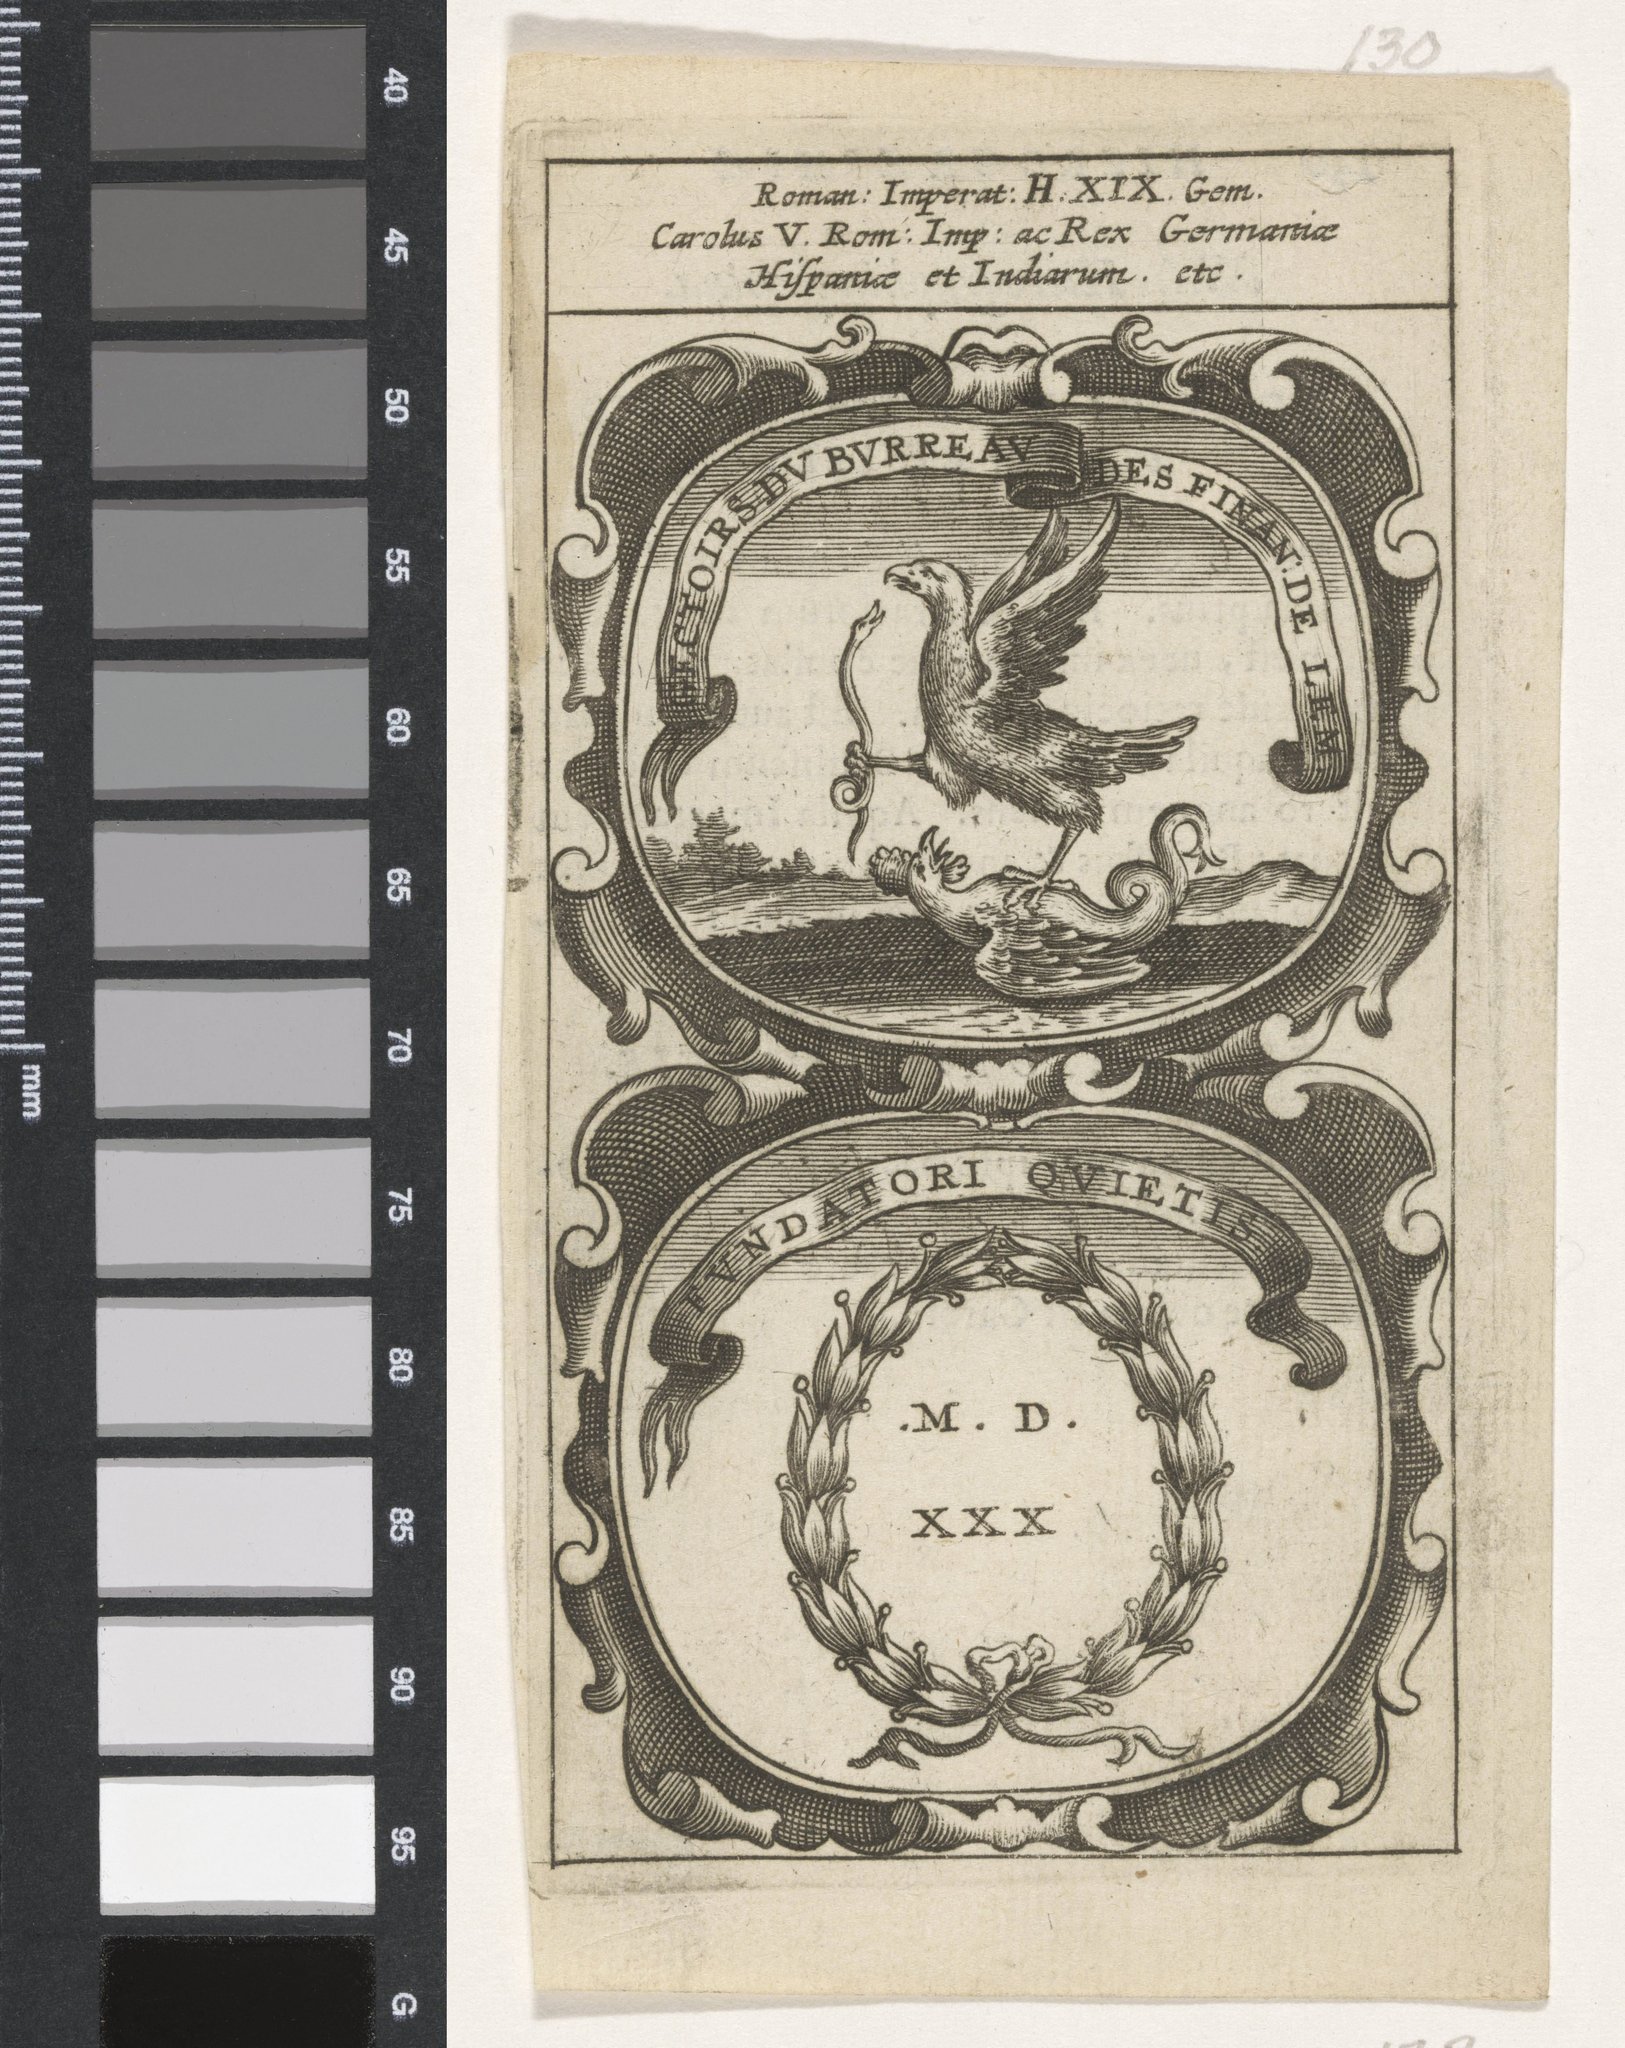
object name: print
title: Gectoirs Du Burreau Des Finan. De Lem / Fundatori Quietis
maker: Anonymous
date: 1666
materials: paper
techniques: engraving, letterpress printing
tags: ghent, charles v (holy roman emperor and king of spain), snakes, predatory birds, basilisk (cock with posterior of snake)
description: Pagina uit Jacob Typotius, Symbola Divina & Humana Pontificum Imperatorum Regum. Arnhem, J.F. Hagen, 1666 of uit de titeluitgave van 1669 of 1679. Het werk van Typotius werd voor het eerst uitgegeven in 1601 met prenten van Aegidius Sadeler.